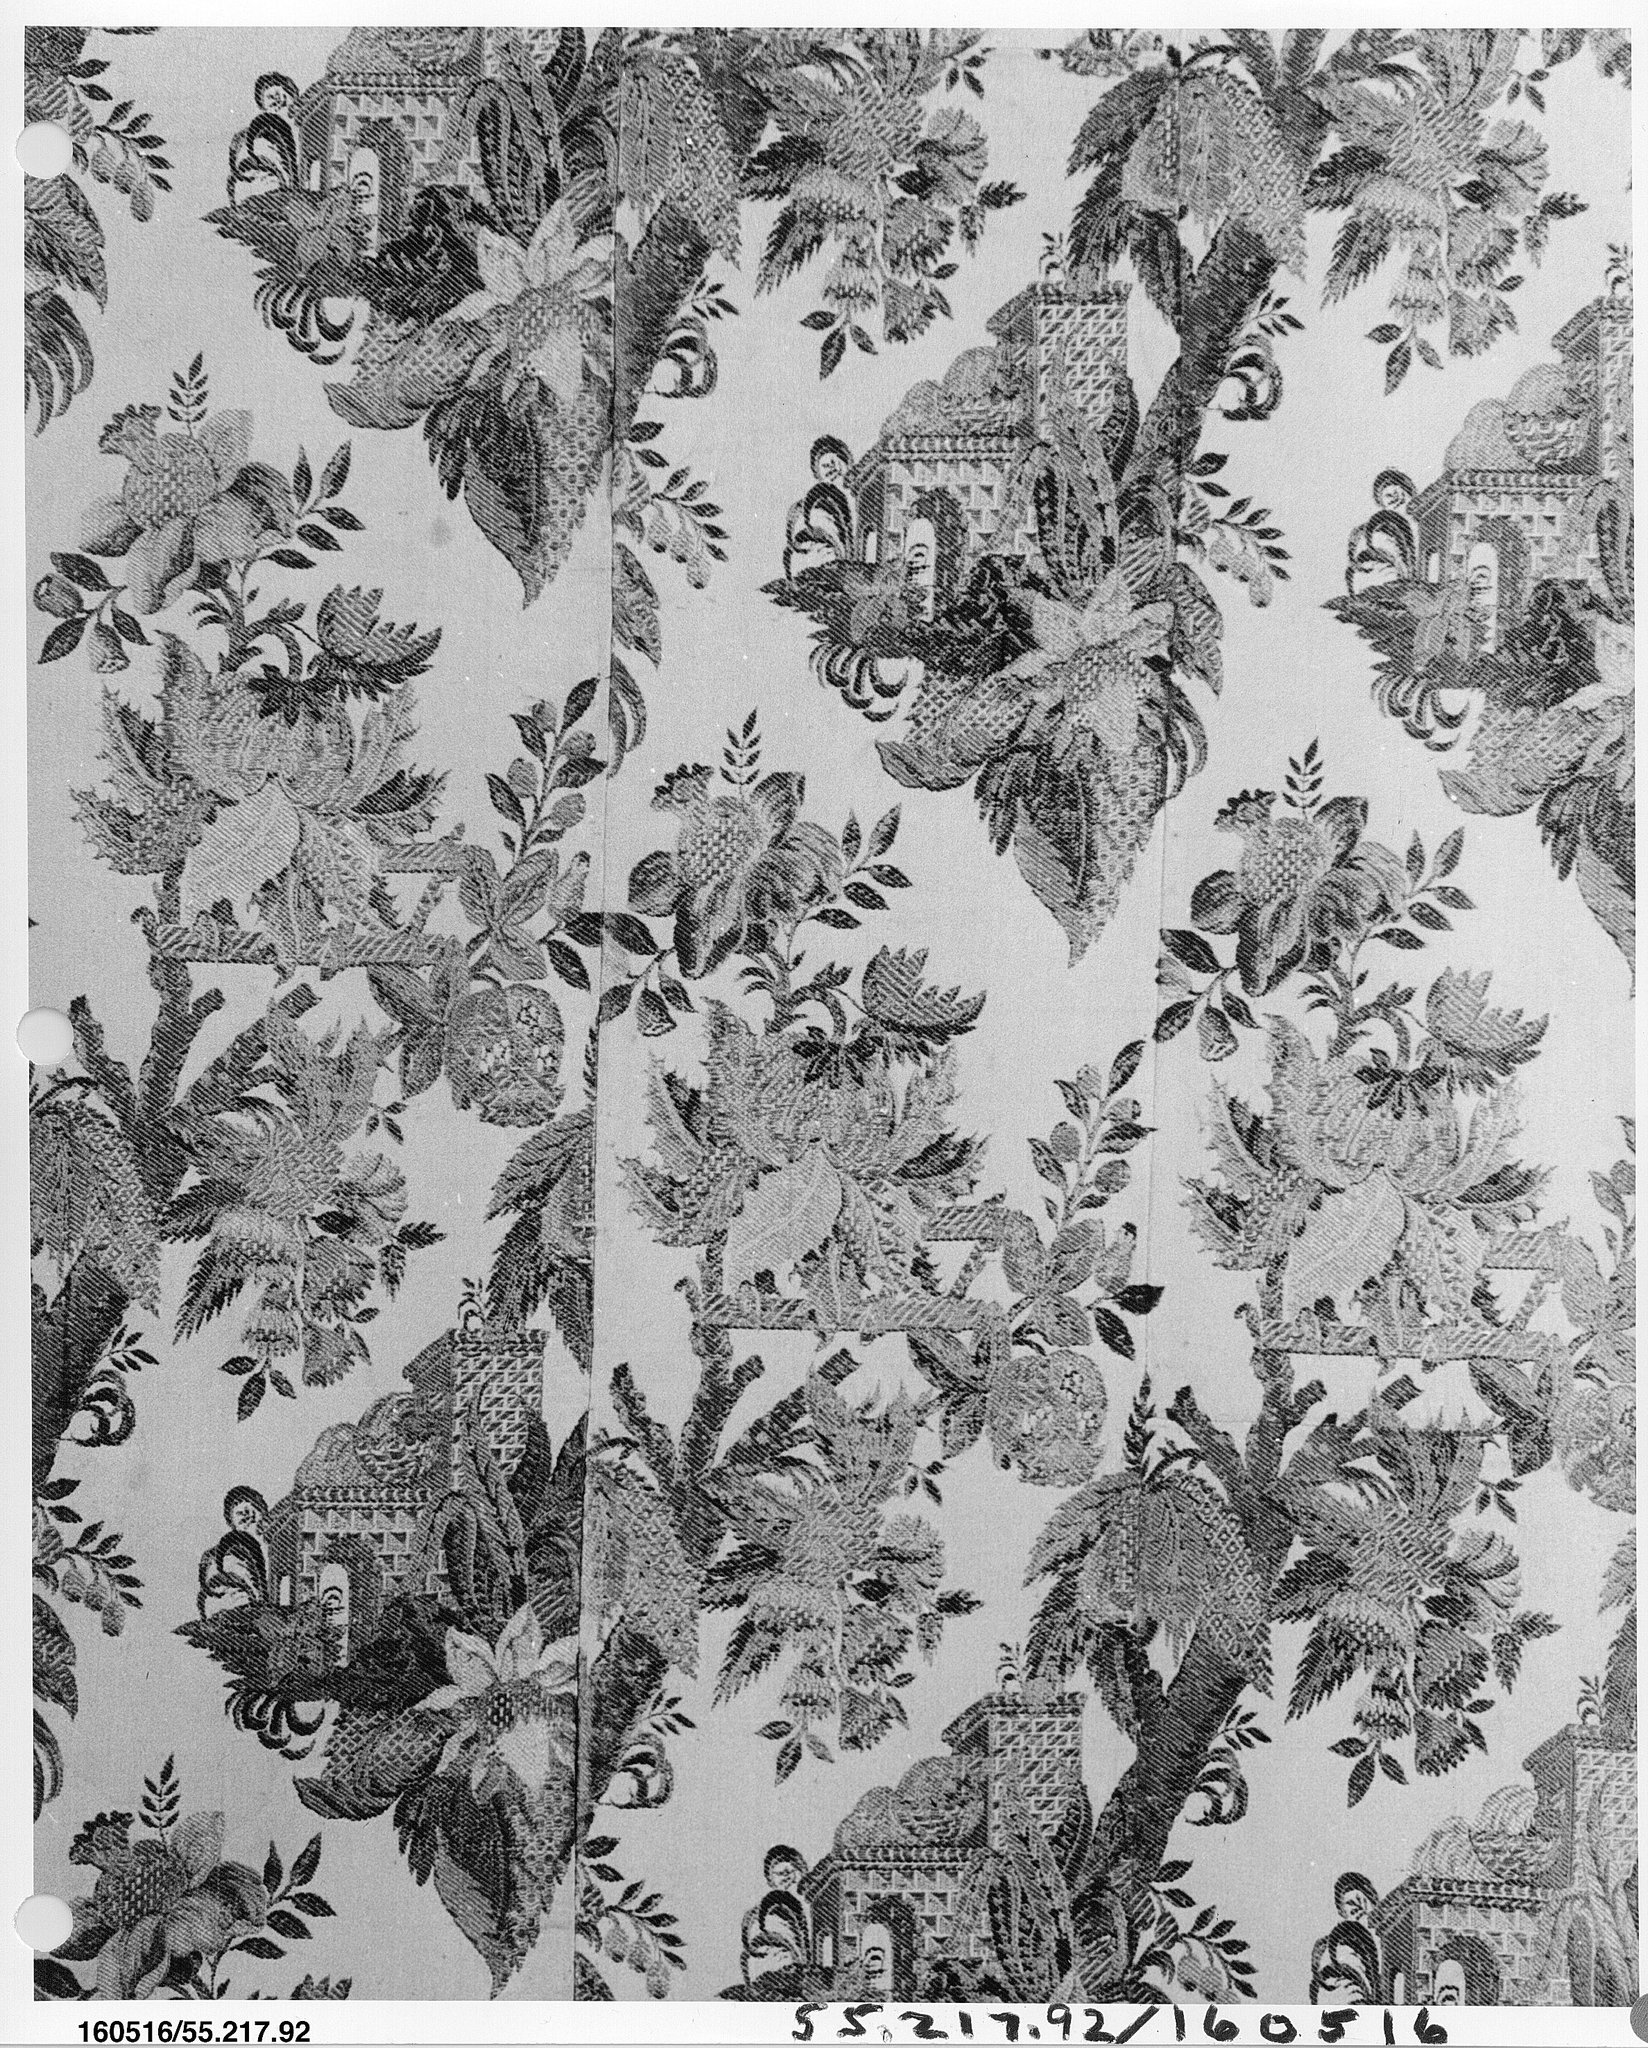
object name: piece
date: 1730-1733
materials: metal thread, silk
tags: buildings,flowers,leaves